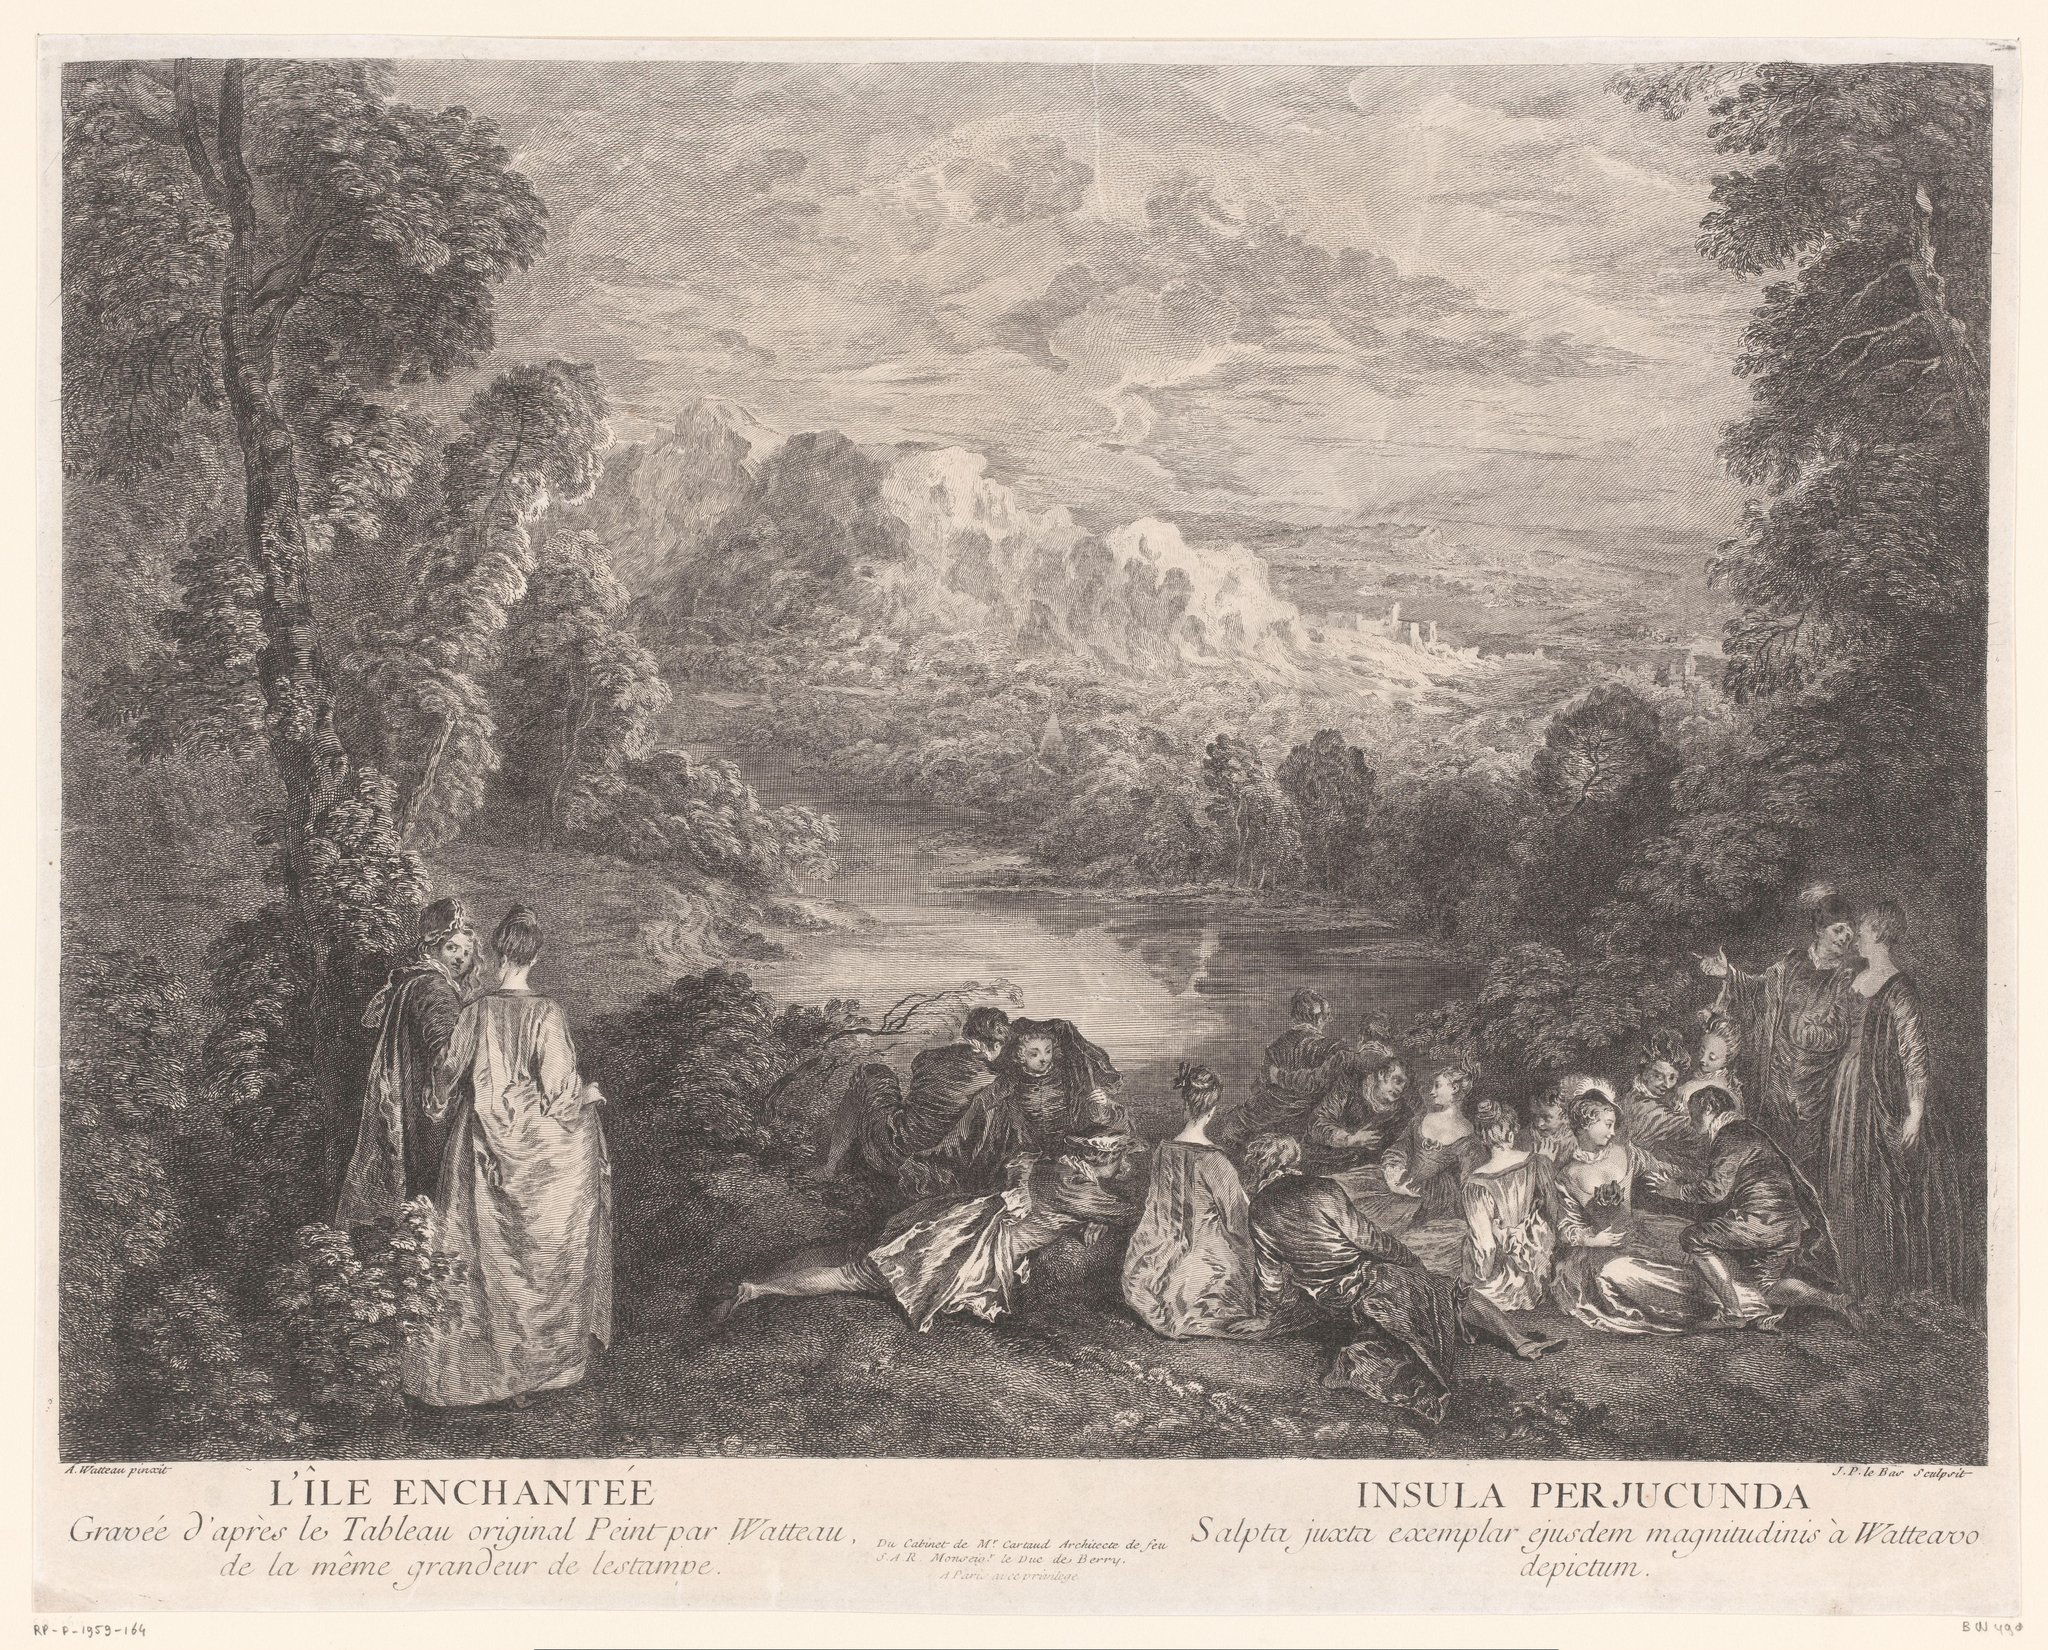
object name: print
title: Elegant gezelschap in een landschap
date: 1734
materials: paper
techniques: engraving, etching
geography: paris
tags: garden of love, court of love, 'fête galante'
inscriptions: collector's mark: Lugt 2760, collector's mark: Lugt 2228